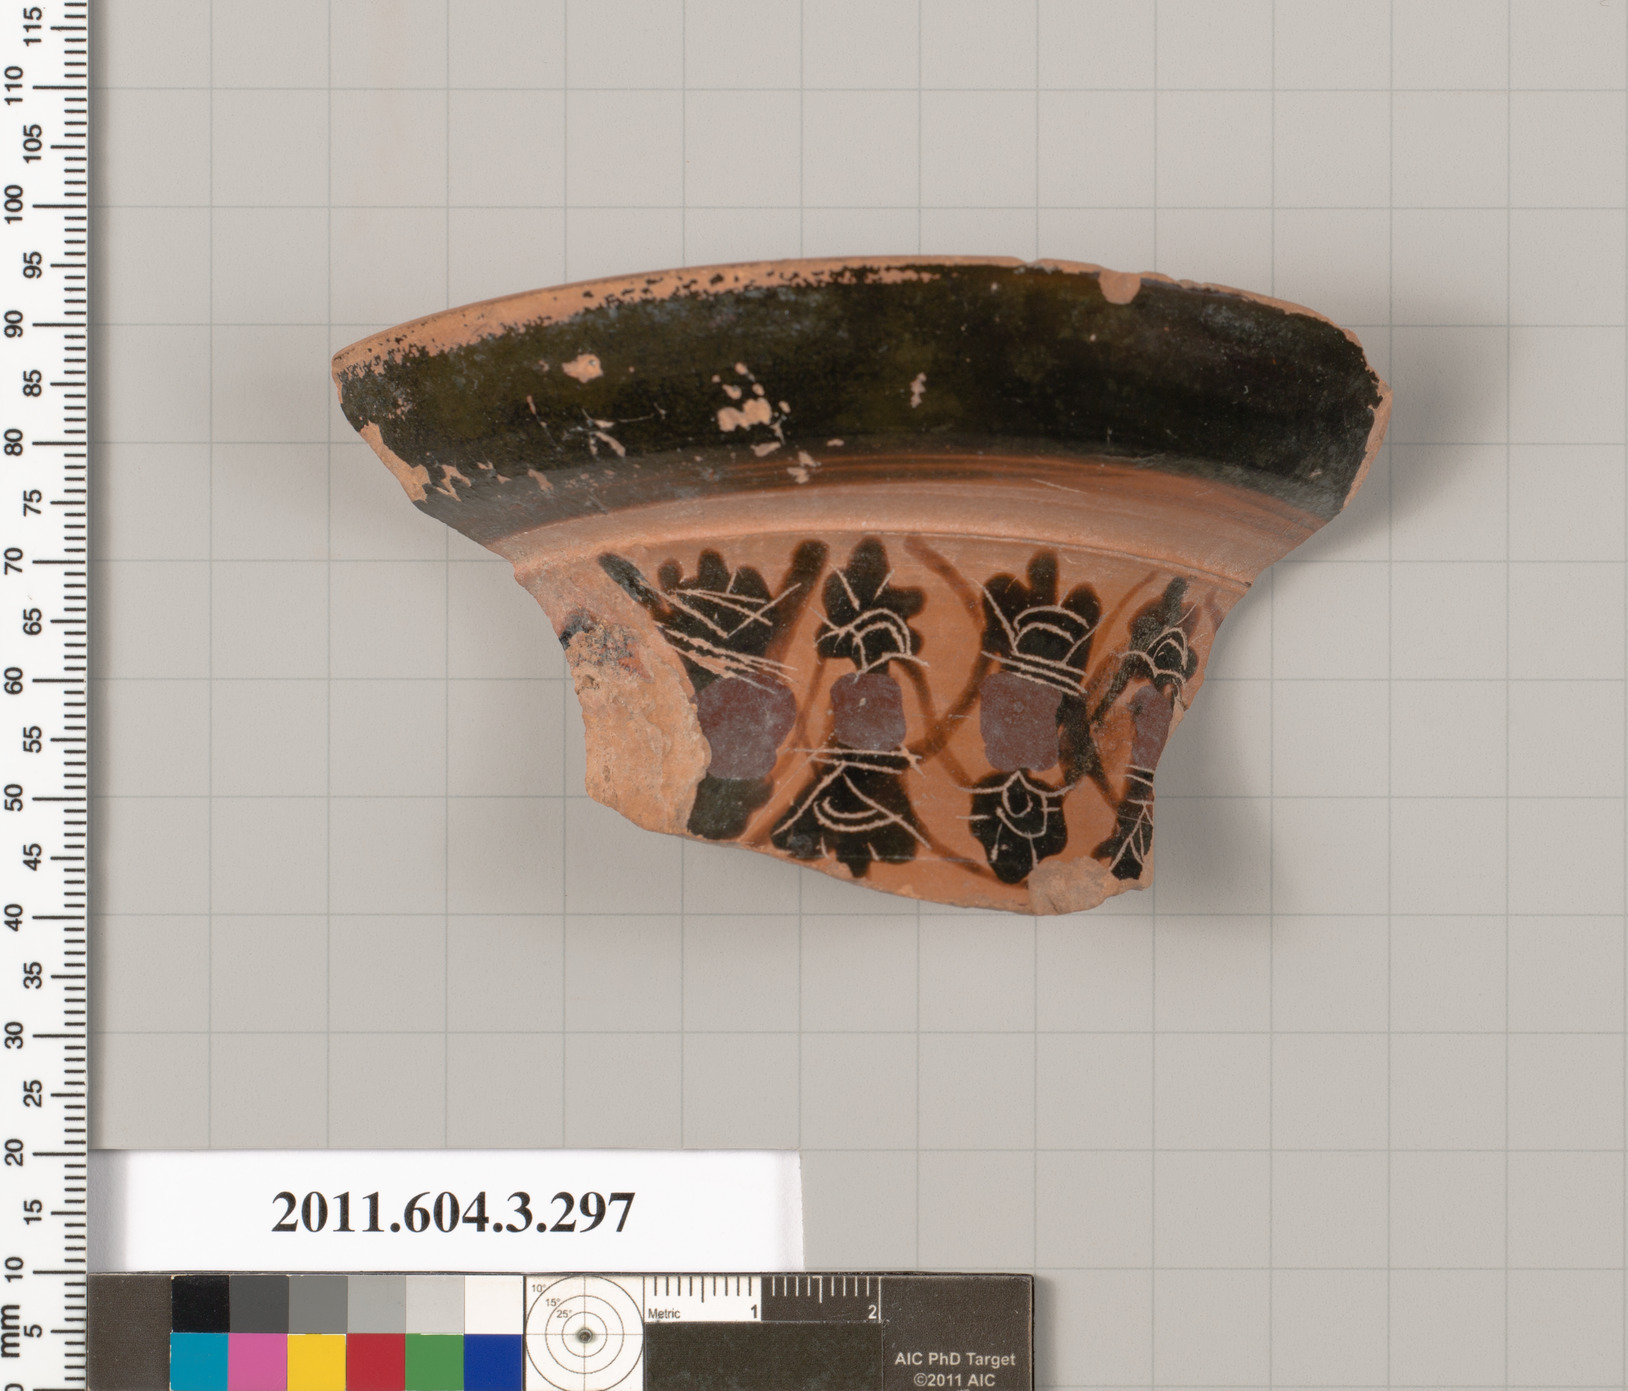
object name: neck amphora fragment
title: Terracotta fragment of a neck-amphora (jar)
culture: greek, attic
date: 575-551 BCE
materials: terracotta